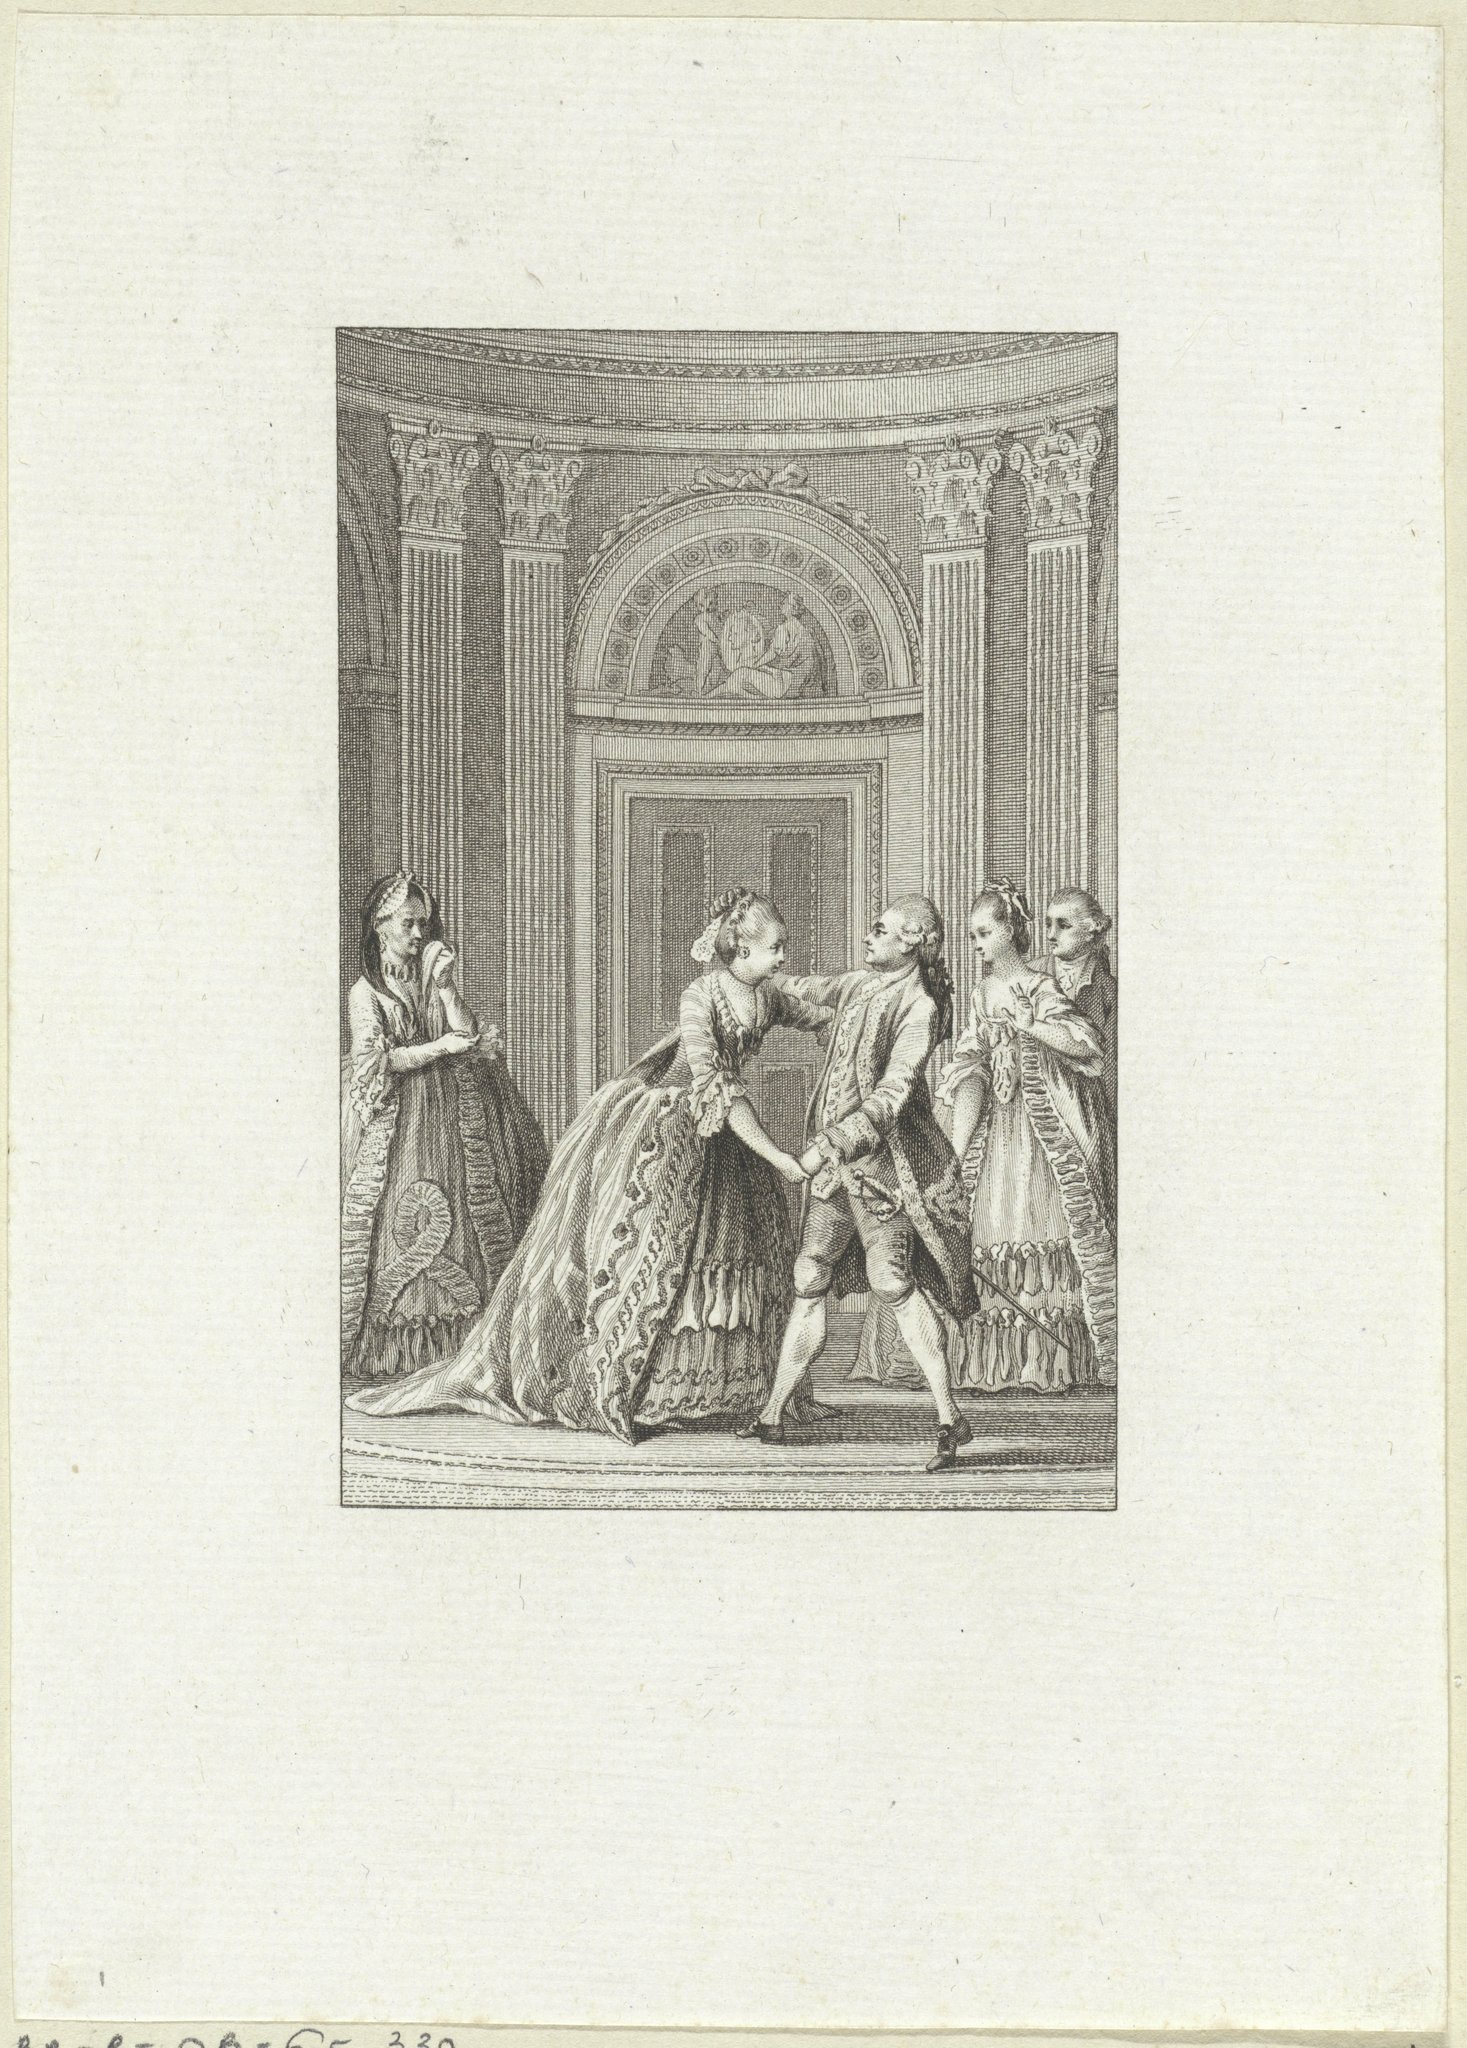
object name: print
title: Emilia en de graaf van Olsbach omhelzen elkaar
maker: reinier vinkeles (i)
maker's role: draughtsman, print maker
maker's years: 1741-1816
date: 1776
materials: paper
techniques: engraving, etching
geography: amsterdam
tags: (lovers) embracing each other, 'symplegma', handkerchief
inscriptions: collector's mark: Lugt 240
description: Proefdruk van illustratie die mogelijk is gebruikt in: Brandes, Johann Christian. De graaf van Olsbach, of De belooning der deugd. Amsterdam: Pieter Meijer, 1776.